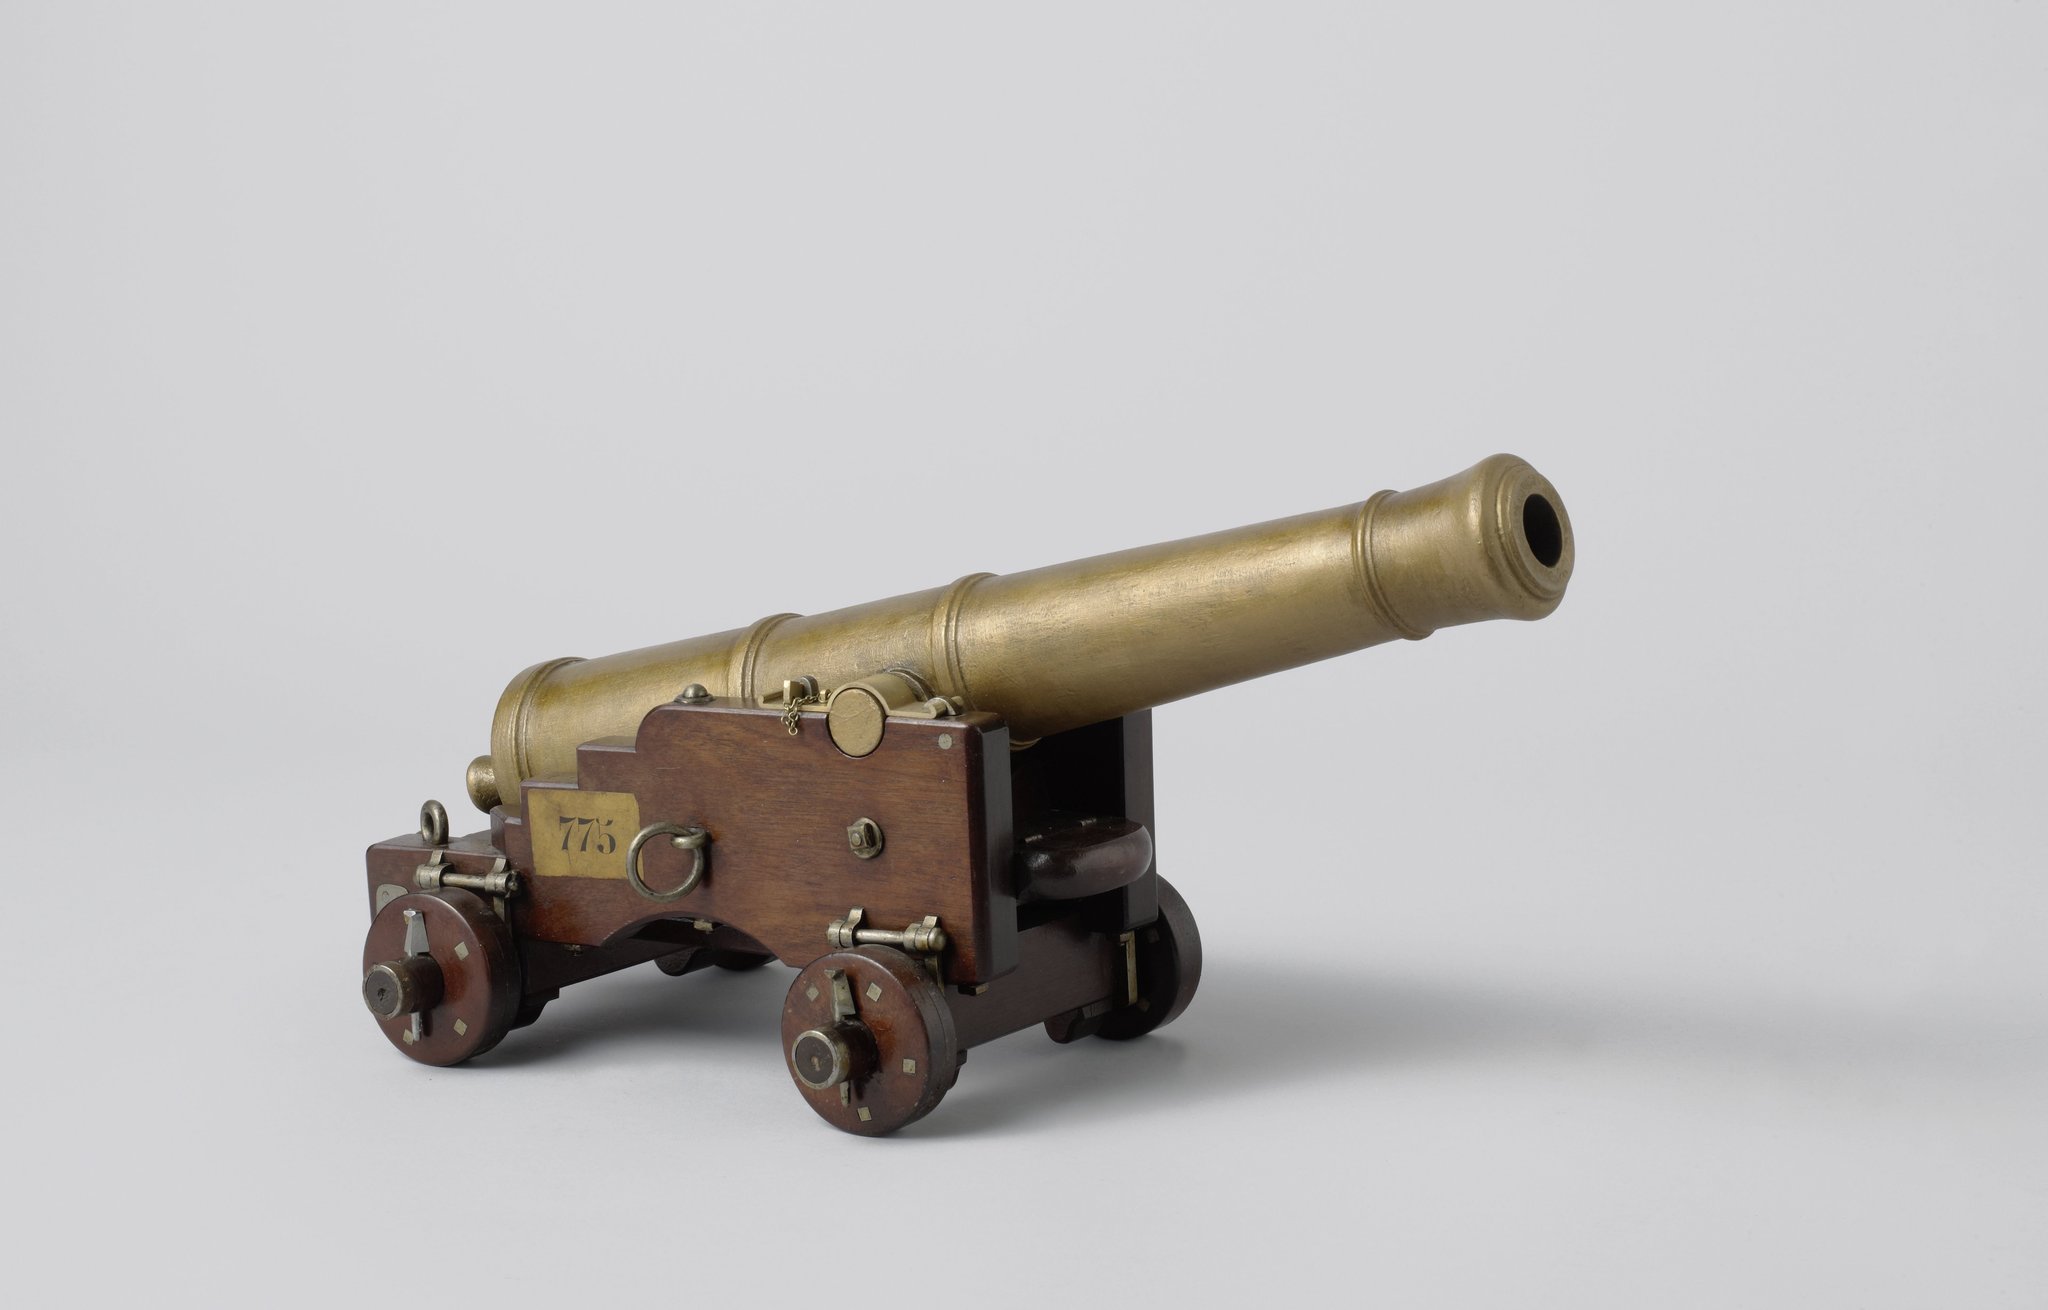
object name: demonstration model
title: Model of an 18-Pounder Gun on Carriage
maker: Anonymous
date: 1800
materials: iron, paint, wood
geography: rotterdam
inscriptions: label, on the carriage: ‘775’ former inventory label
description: The heavy artillery on naval ships consisted of cannon mounted on gun carriages. The calibre – or fire power – of naval cannon was expressed in pounds, according to the weight of the projectiles. The set on this plank represents guns of decreasing calibre, ranging from 36 pounds (far left), 30, 24 and 18 pounds to 12 pounds.